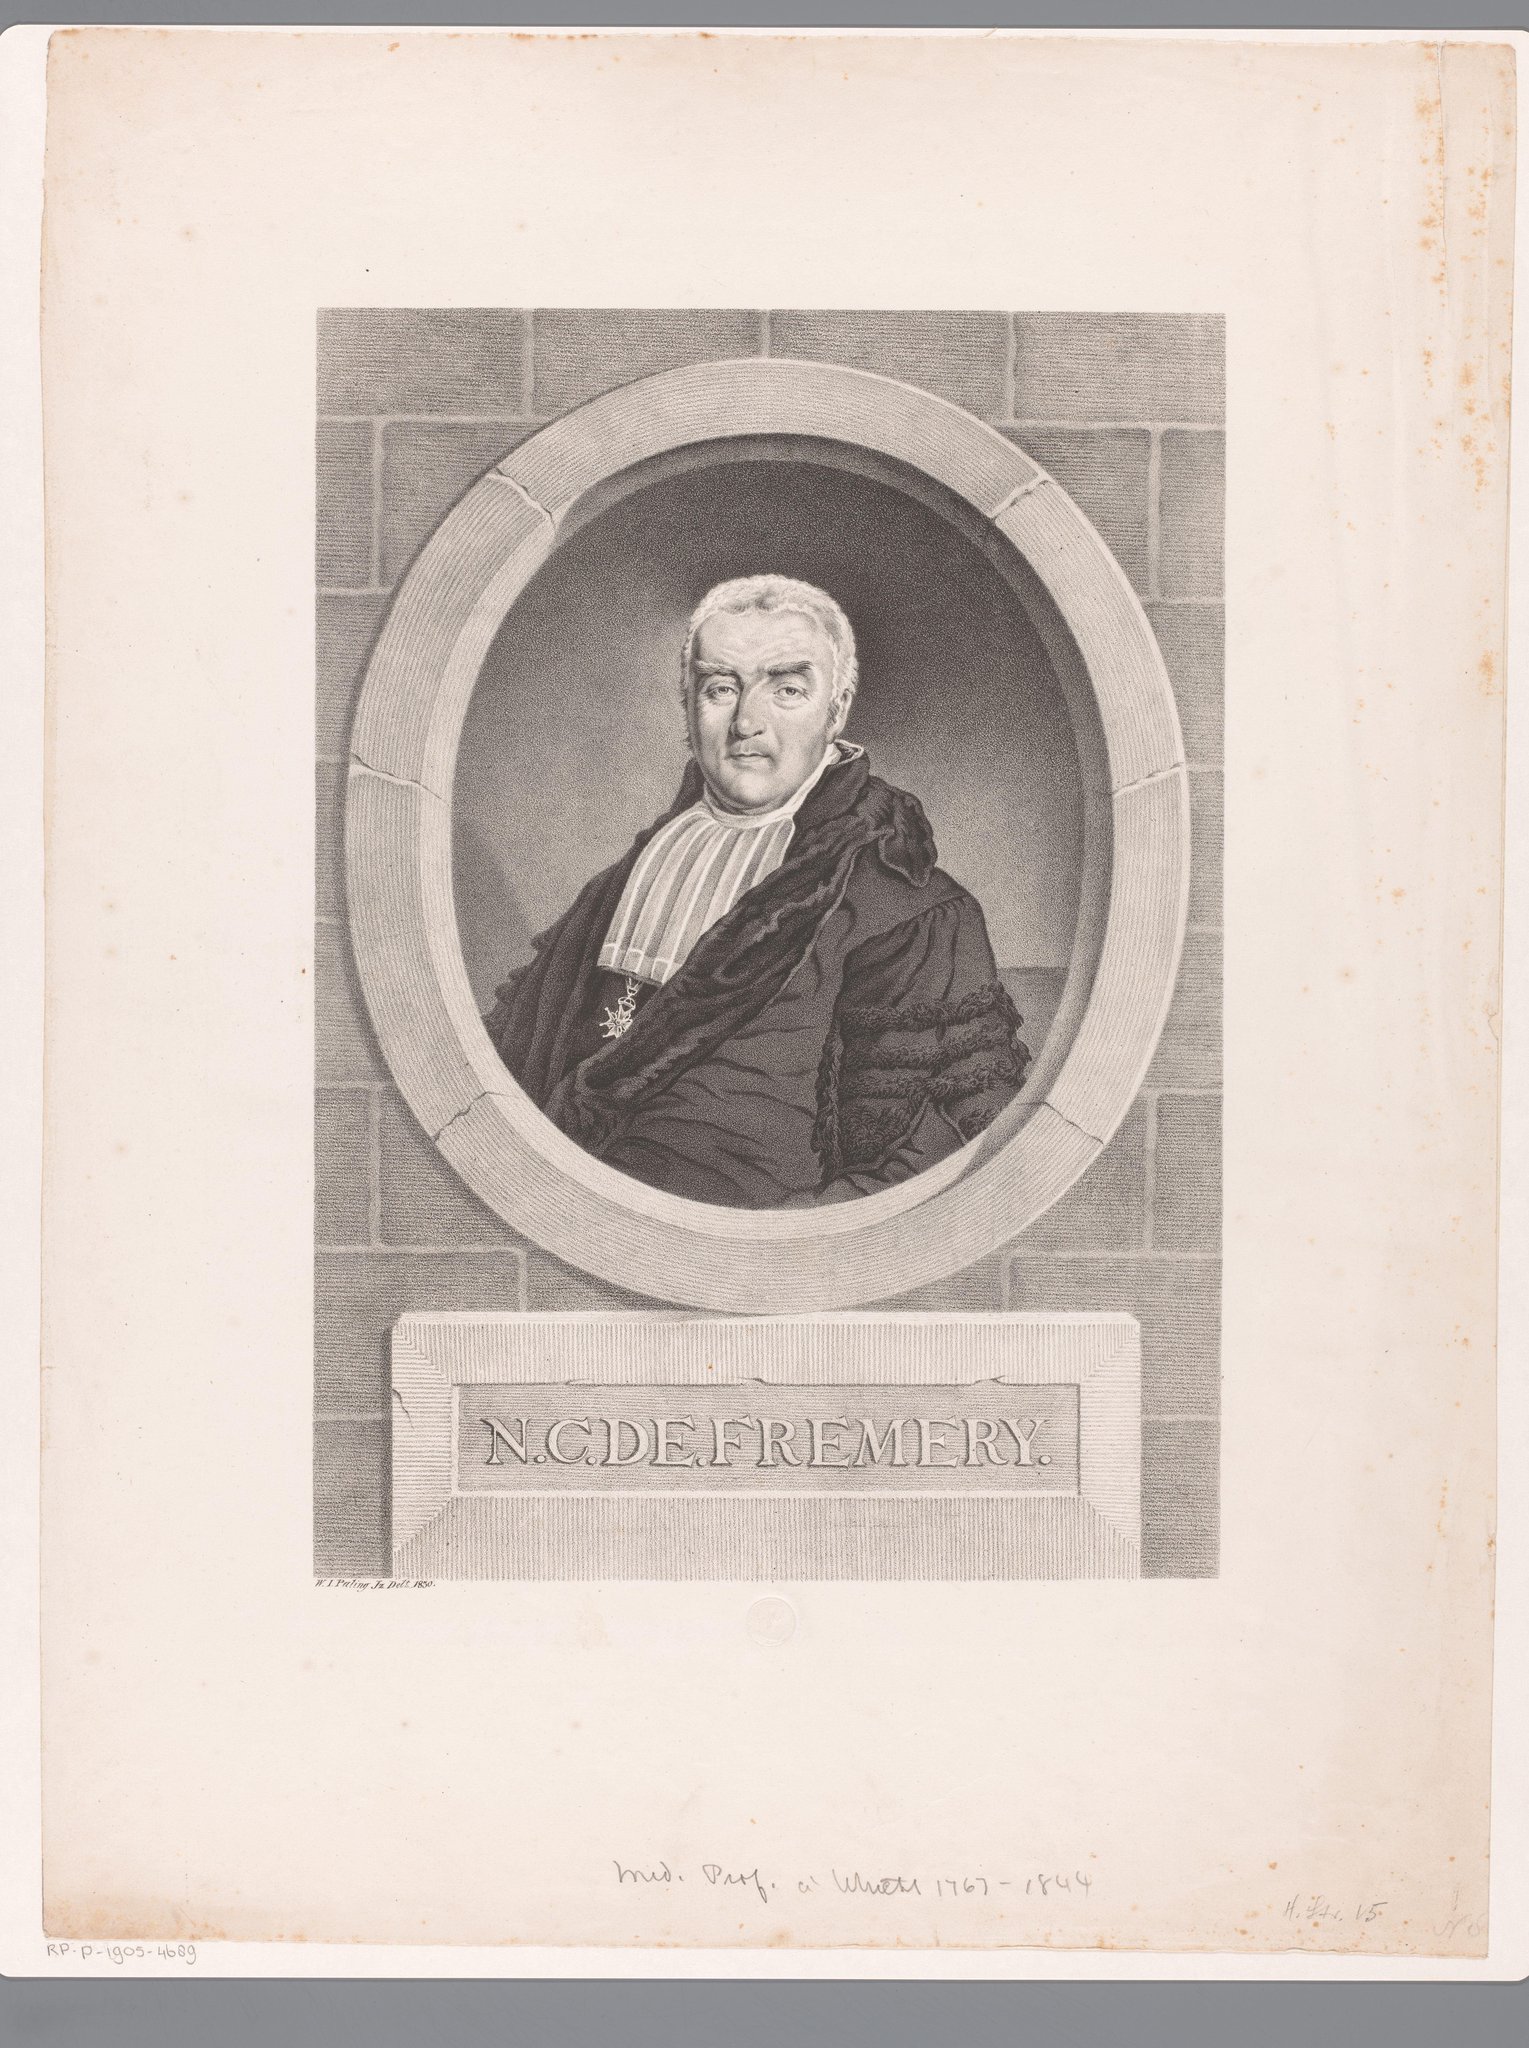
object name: print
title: Portret van Nicolaas Cornelis de Fremery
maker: willem jan paling jz.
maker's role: print maker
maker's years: 1776-1848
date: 1830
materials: paper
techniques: lithograph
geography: netherlands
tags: overschie, utrecht, historical persons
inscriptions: collector's mark: Lugt 2228, check stamp